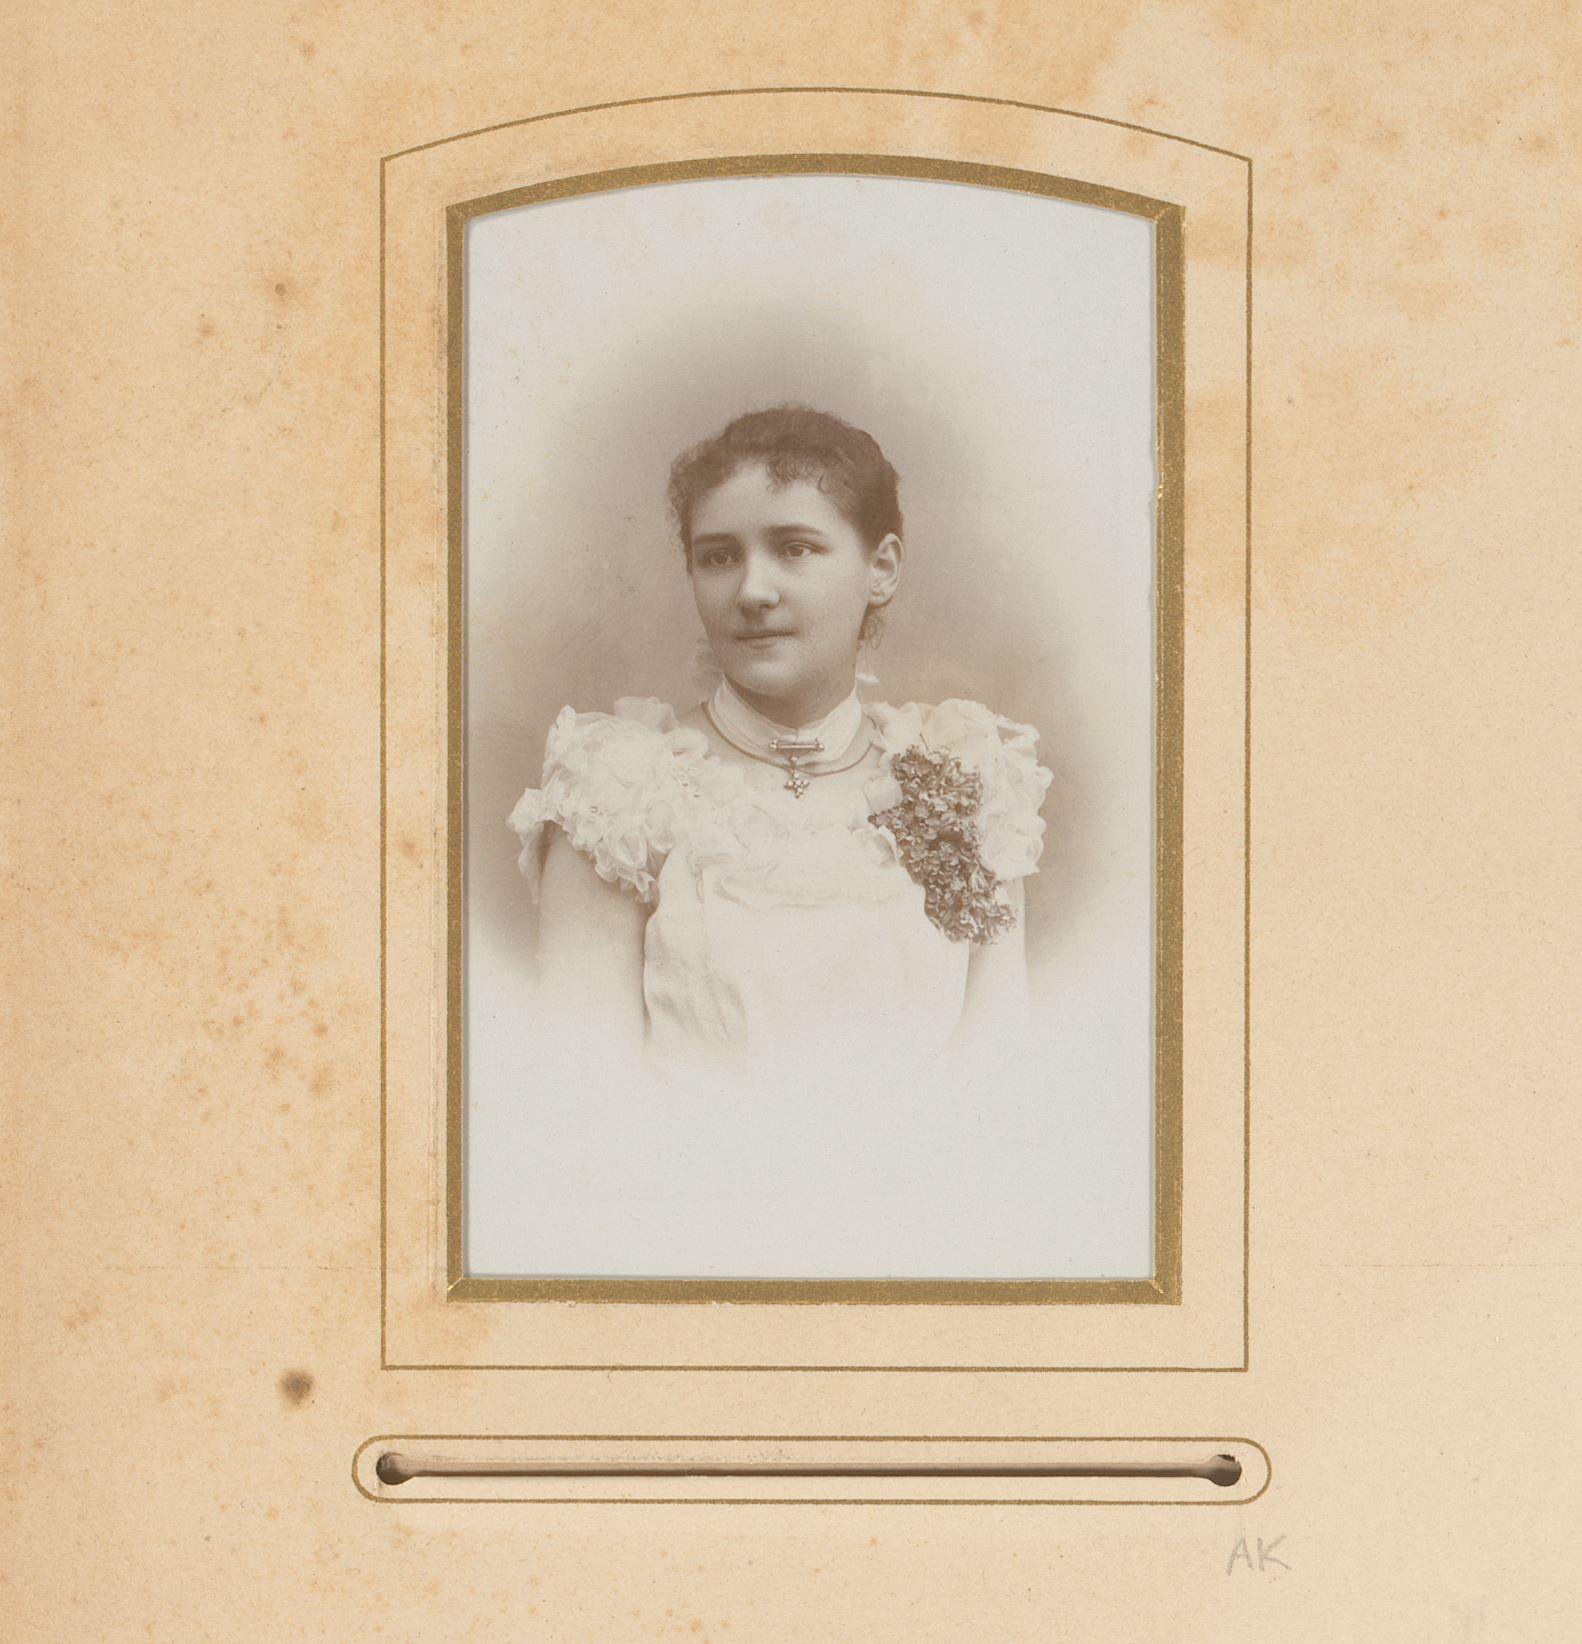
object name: carte de visite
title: Portret van een jonge vrouw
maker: p. both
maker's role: fotograaf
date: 1880-1920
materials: cardboard, photographic support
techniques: collodion silver print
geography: arnstadt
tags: adolescent, young woman, maiden, historical persons - bb - woman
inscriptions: inscription: ‘Atelier für Photographie von/ [...]/ [...]TADT/ am Riedthor./ Von diesem Bilde können stets nachbestellungen/ und Vergrösserungen angefertigt werden.’, annotation: ‘Zu [...] Erinnerung/ von [...] Bertha [Mallo..]’